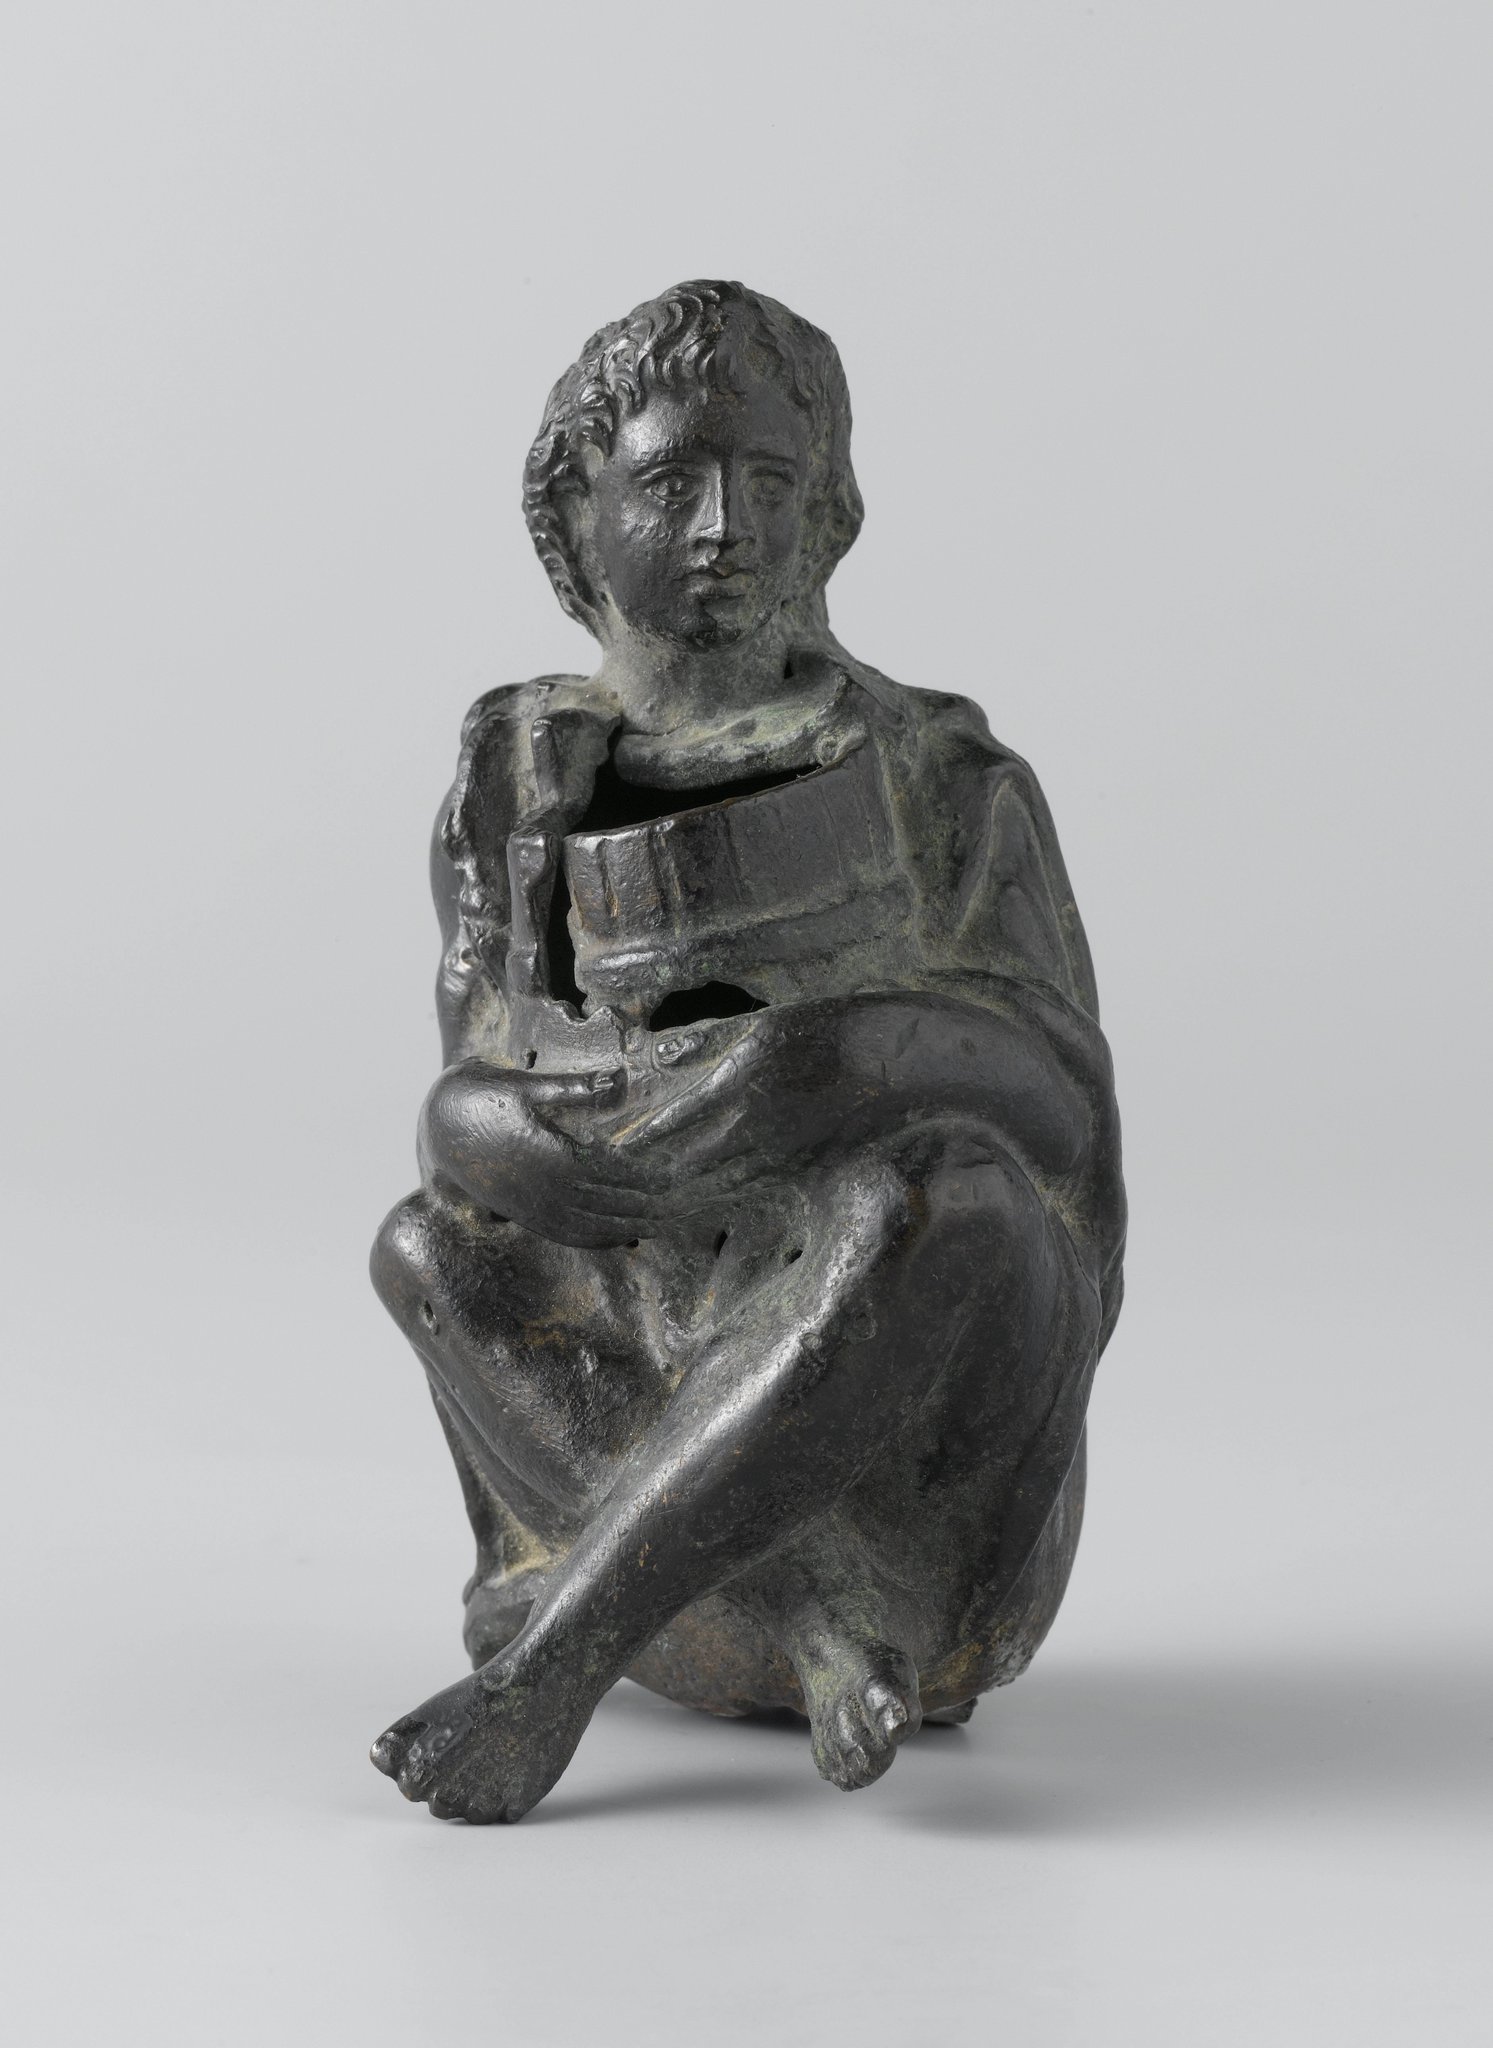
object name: sculpture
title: Zittende knaap met vat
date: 1475-1525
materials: bronze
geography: padua